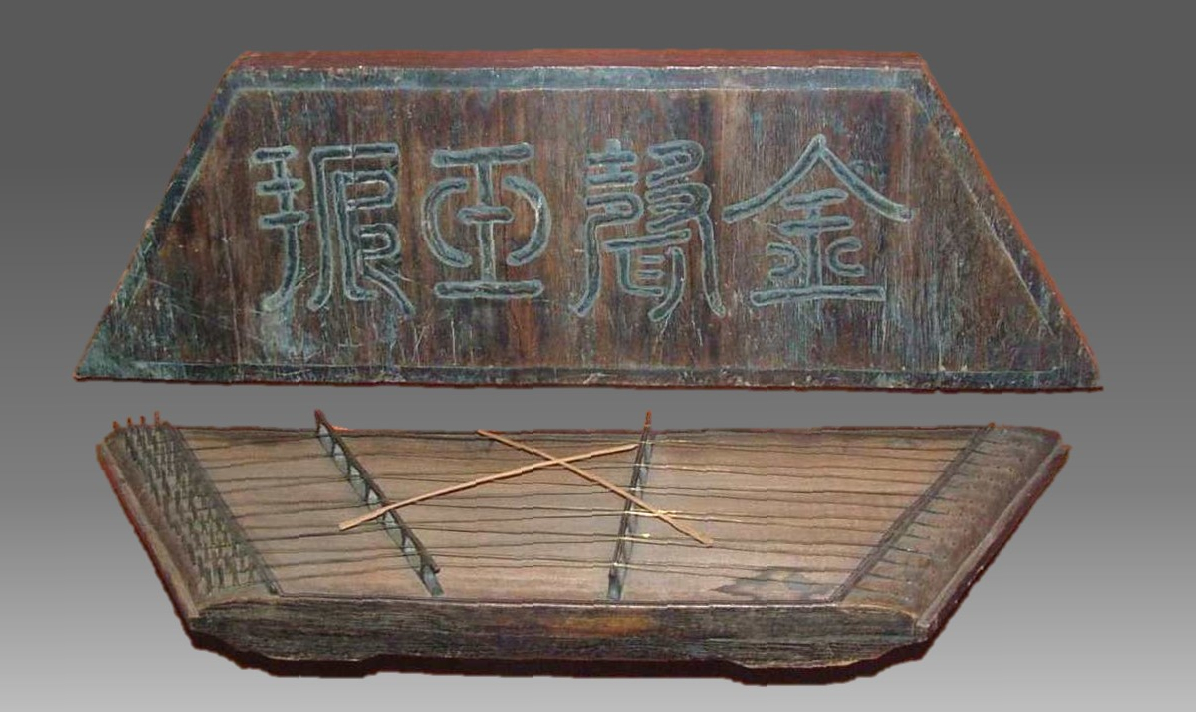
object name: yanggum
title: Yanggum ( 양금 )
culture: korean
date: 1801-1900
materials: metal, wood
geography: korea